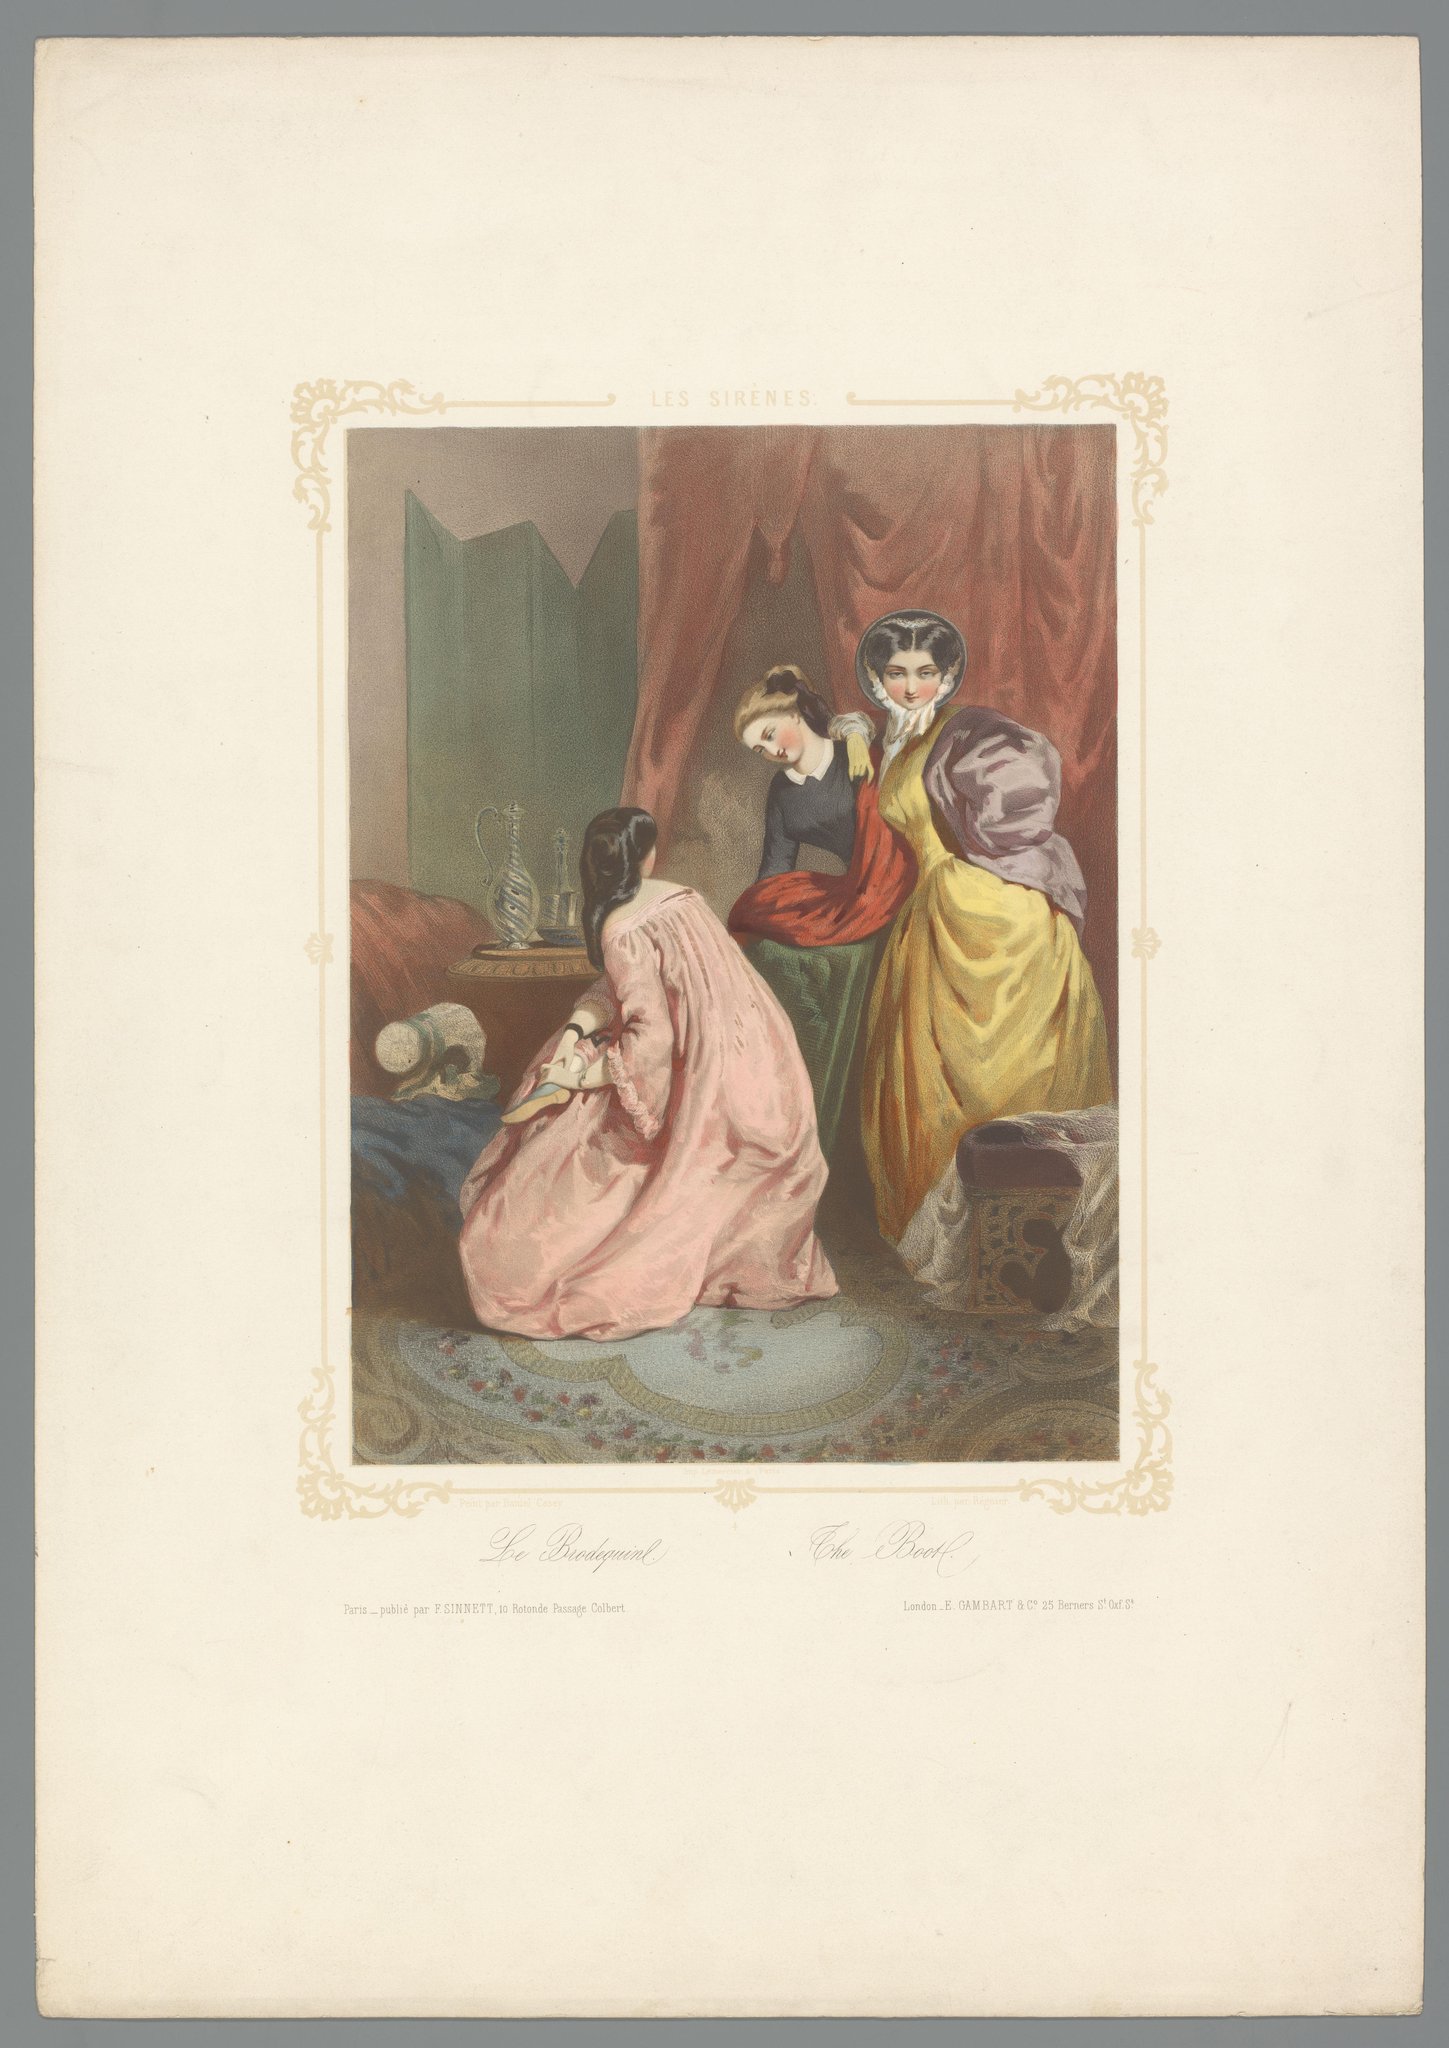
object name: print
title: Les sirènes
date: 1851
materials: paper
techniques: hand coloring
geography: paris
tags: adult woman, boots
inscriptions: collector's mark: Lugt 2228